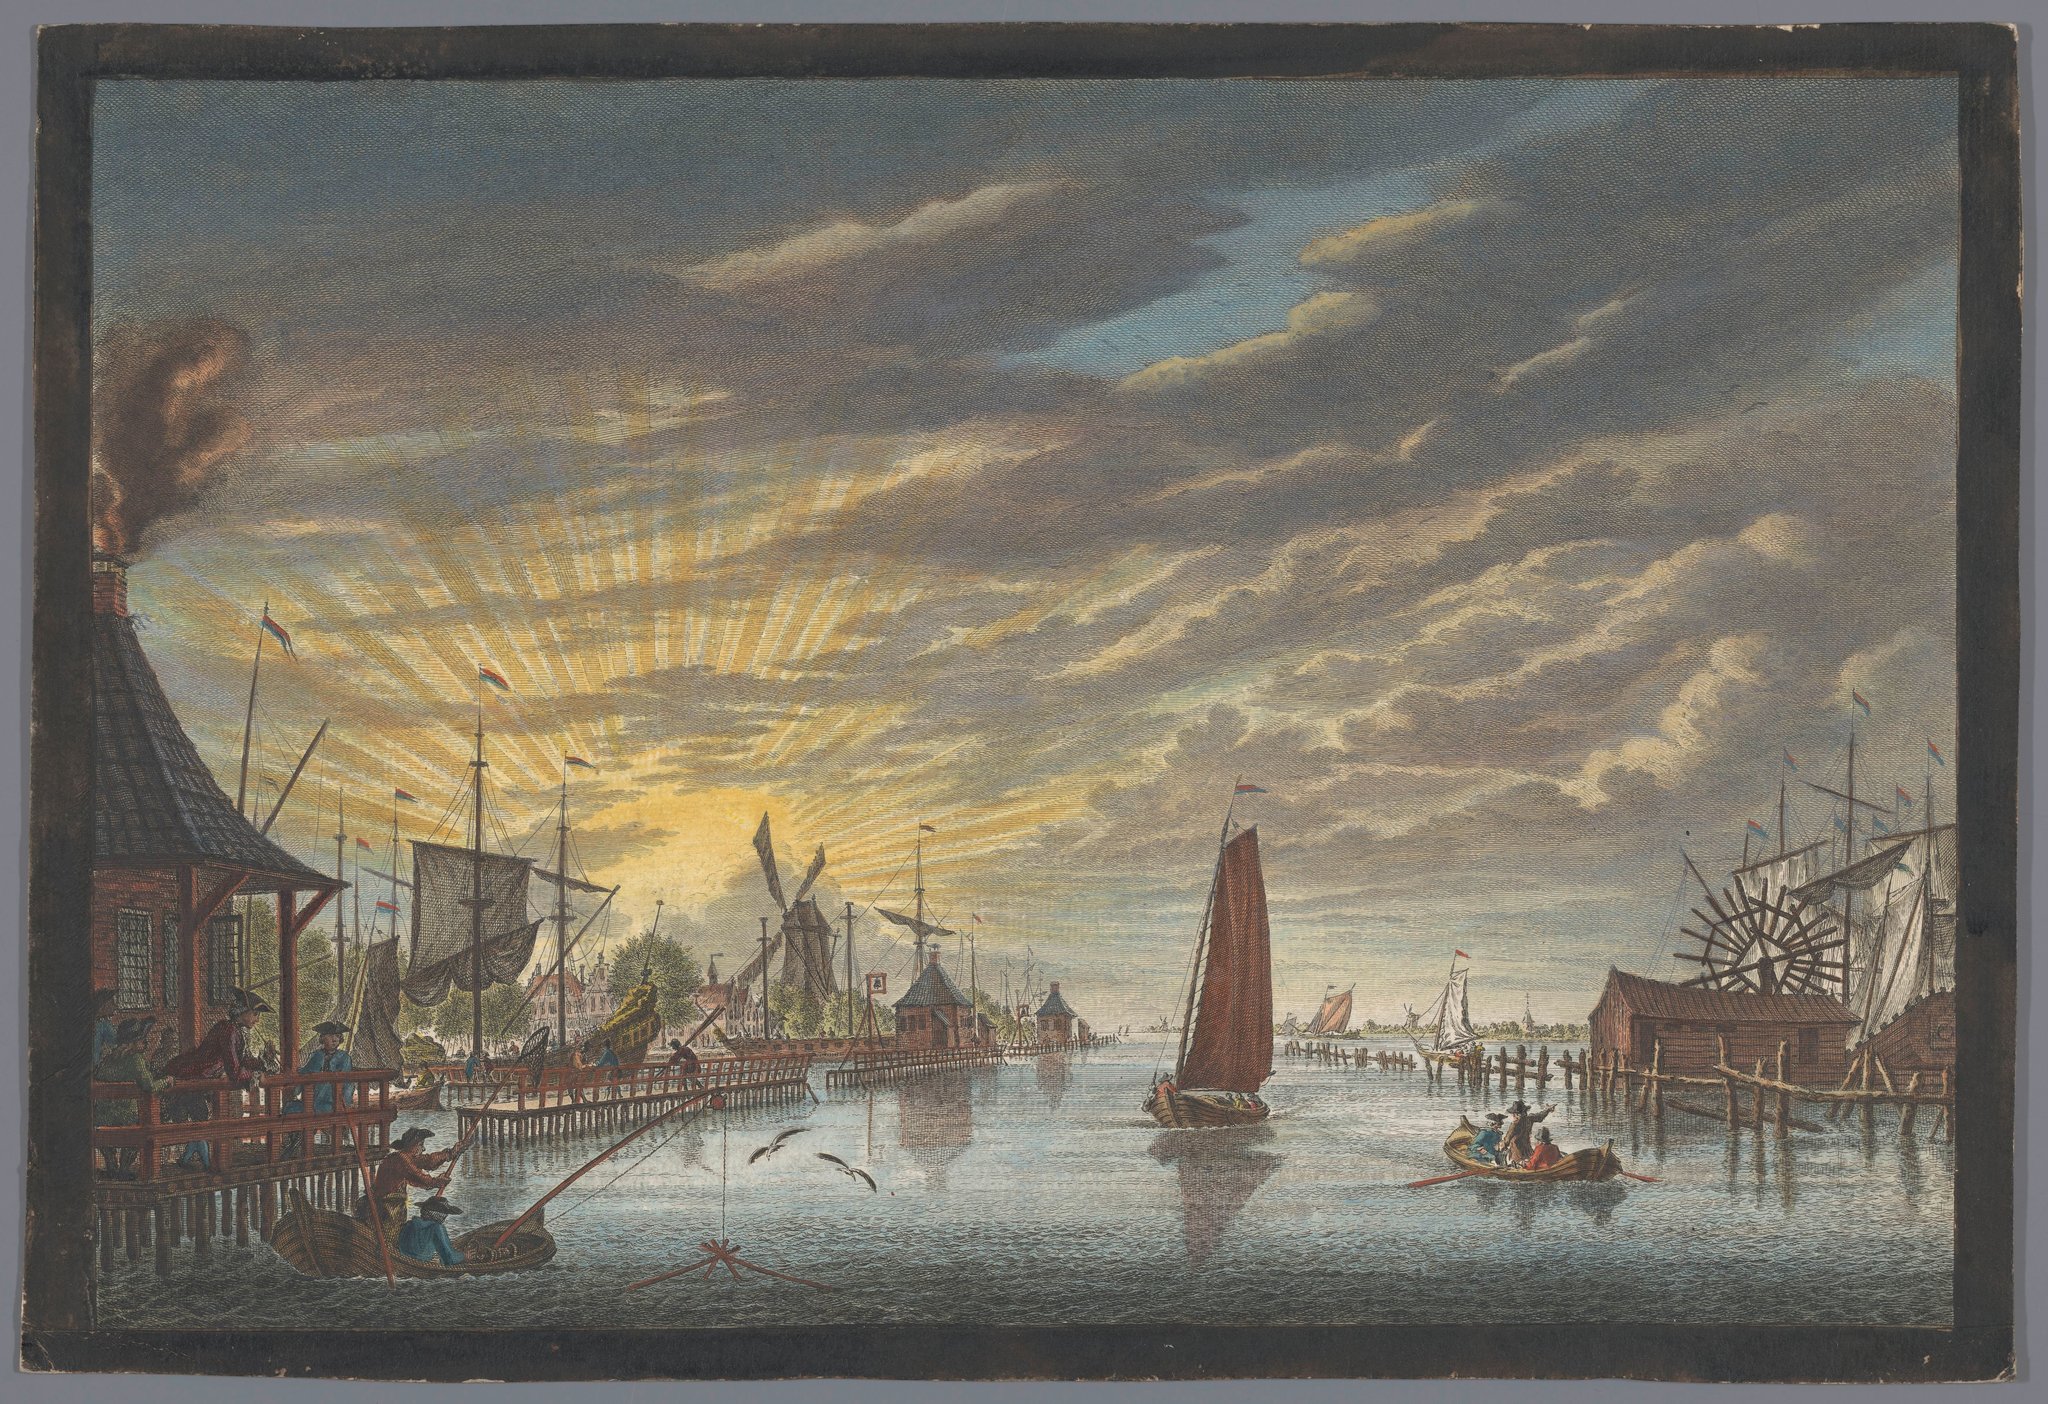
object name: print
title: Gezicht by de oude jagthaven naar 't Blaauwhoofd te zien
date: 1753-1799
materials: cardboard, paper, watercolor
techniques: brush, etching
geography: amsterdam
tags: harbour, sailing-ship, sailing-boat, rowing-boat, canoe, etc., windmill, canals, waters (in city) (+ city(-scape) with figures, staffage), amsterdam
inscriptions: collector's mark: Lugt 2233